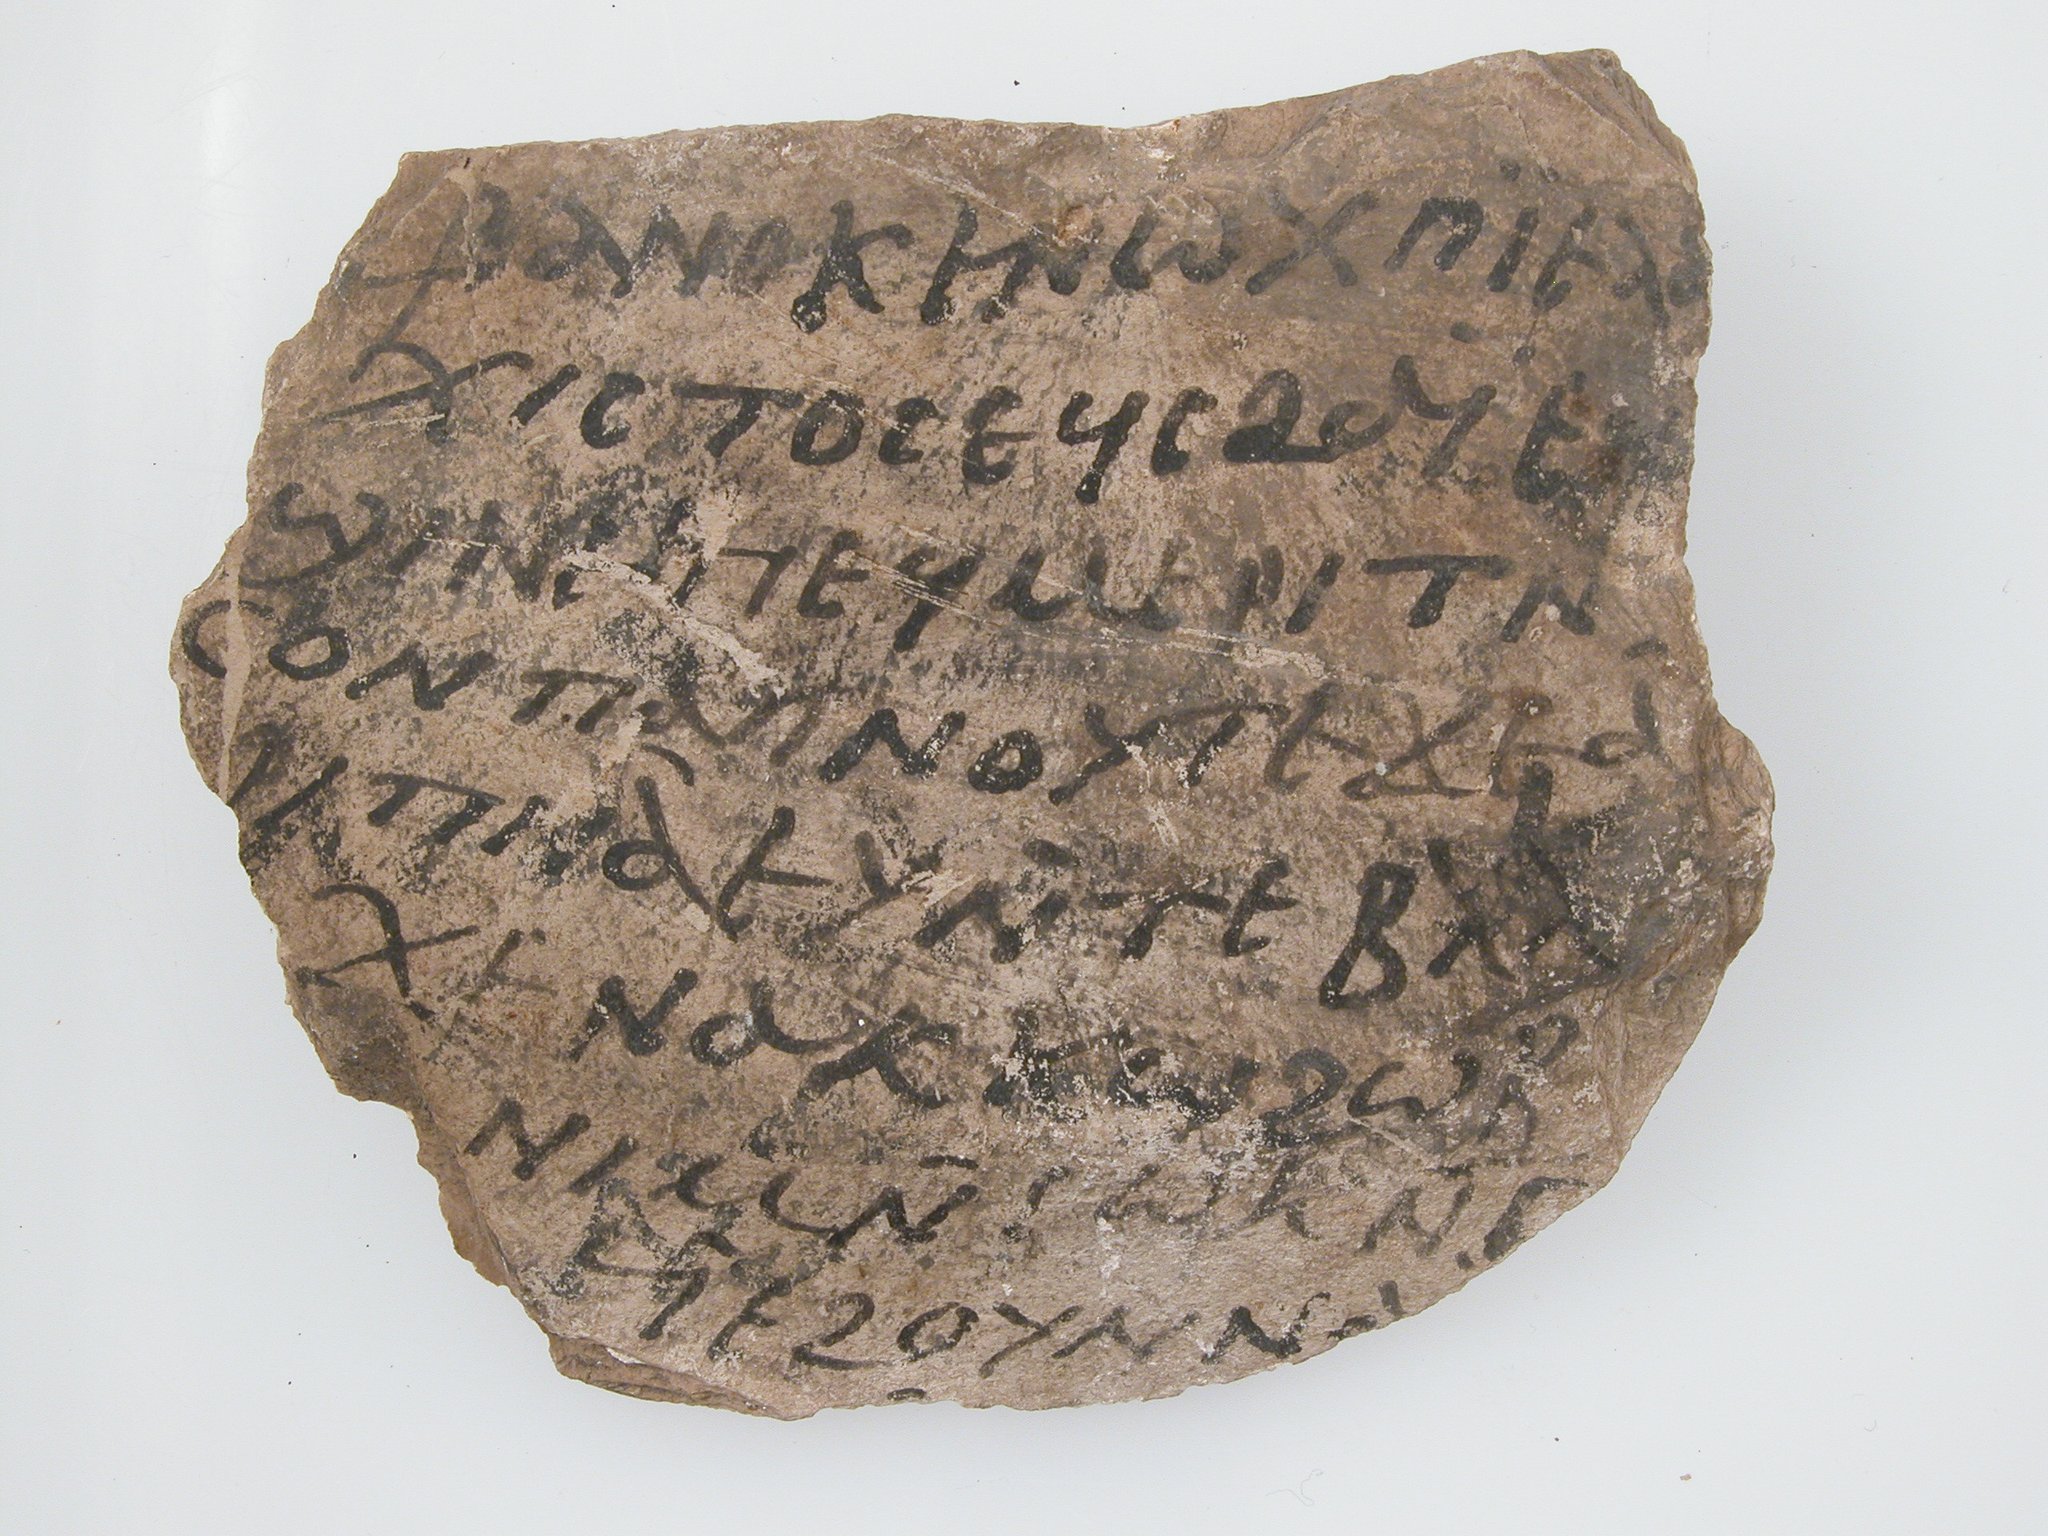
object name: ostrakon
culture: coptic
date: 601-700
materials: ink, limestone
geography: egypt